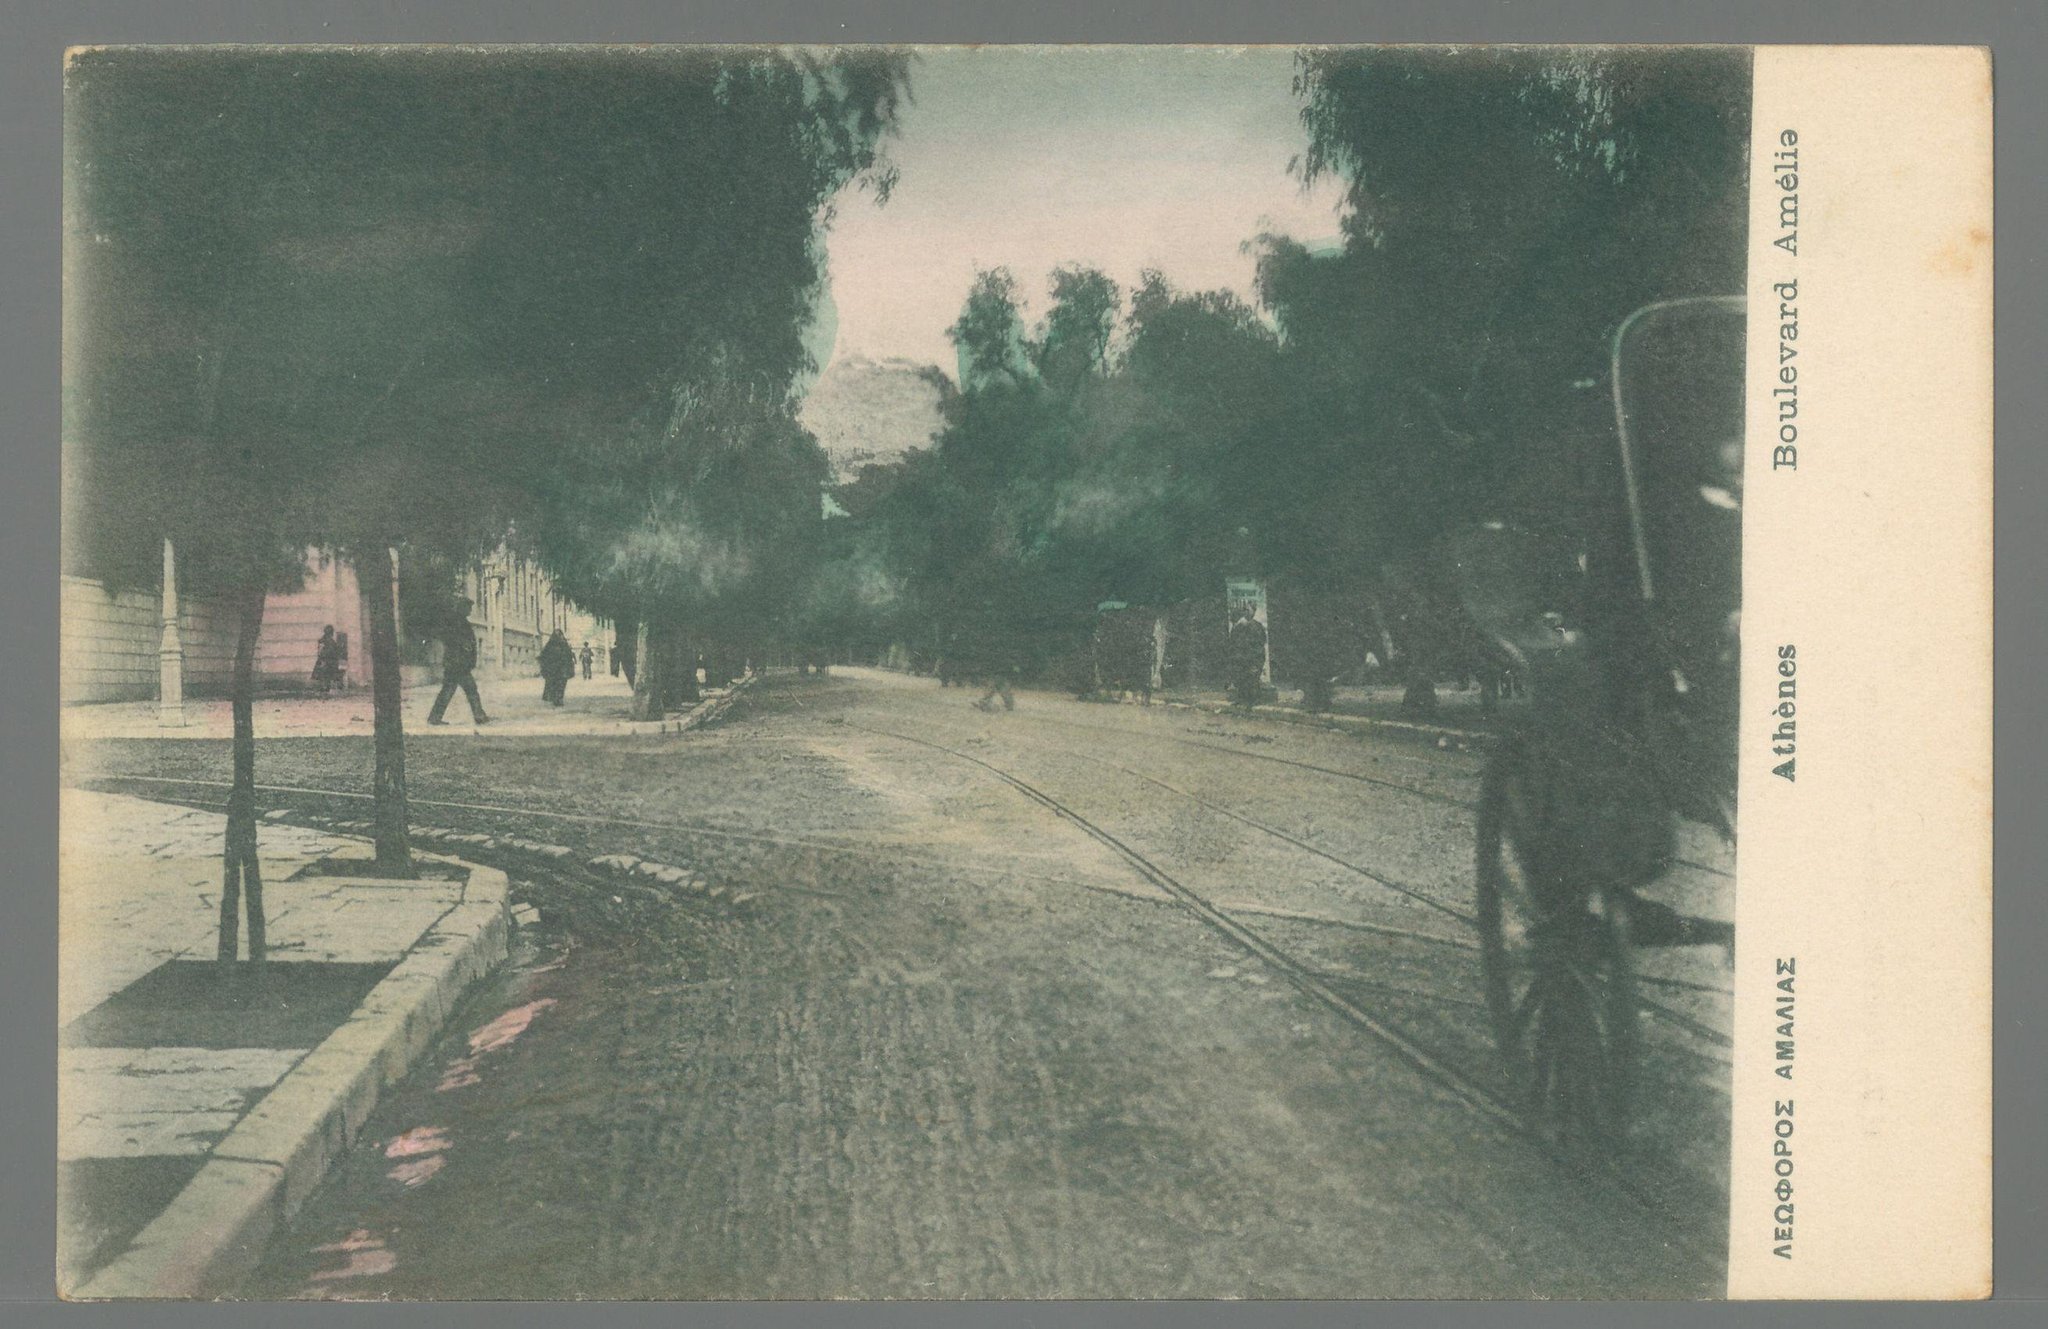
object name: ansichtkaart, prentbriefkaart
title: Athènes. Boulevard Amélia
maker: Anonymous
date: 1906-1930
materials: cardboard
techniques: photograph, hand coloring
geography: athens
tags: avenue, boulevard, promenade, esplanade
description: Voor de Franse titel staat de titel in het Grieks.